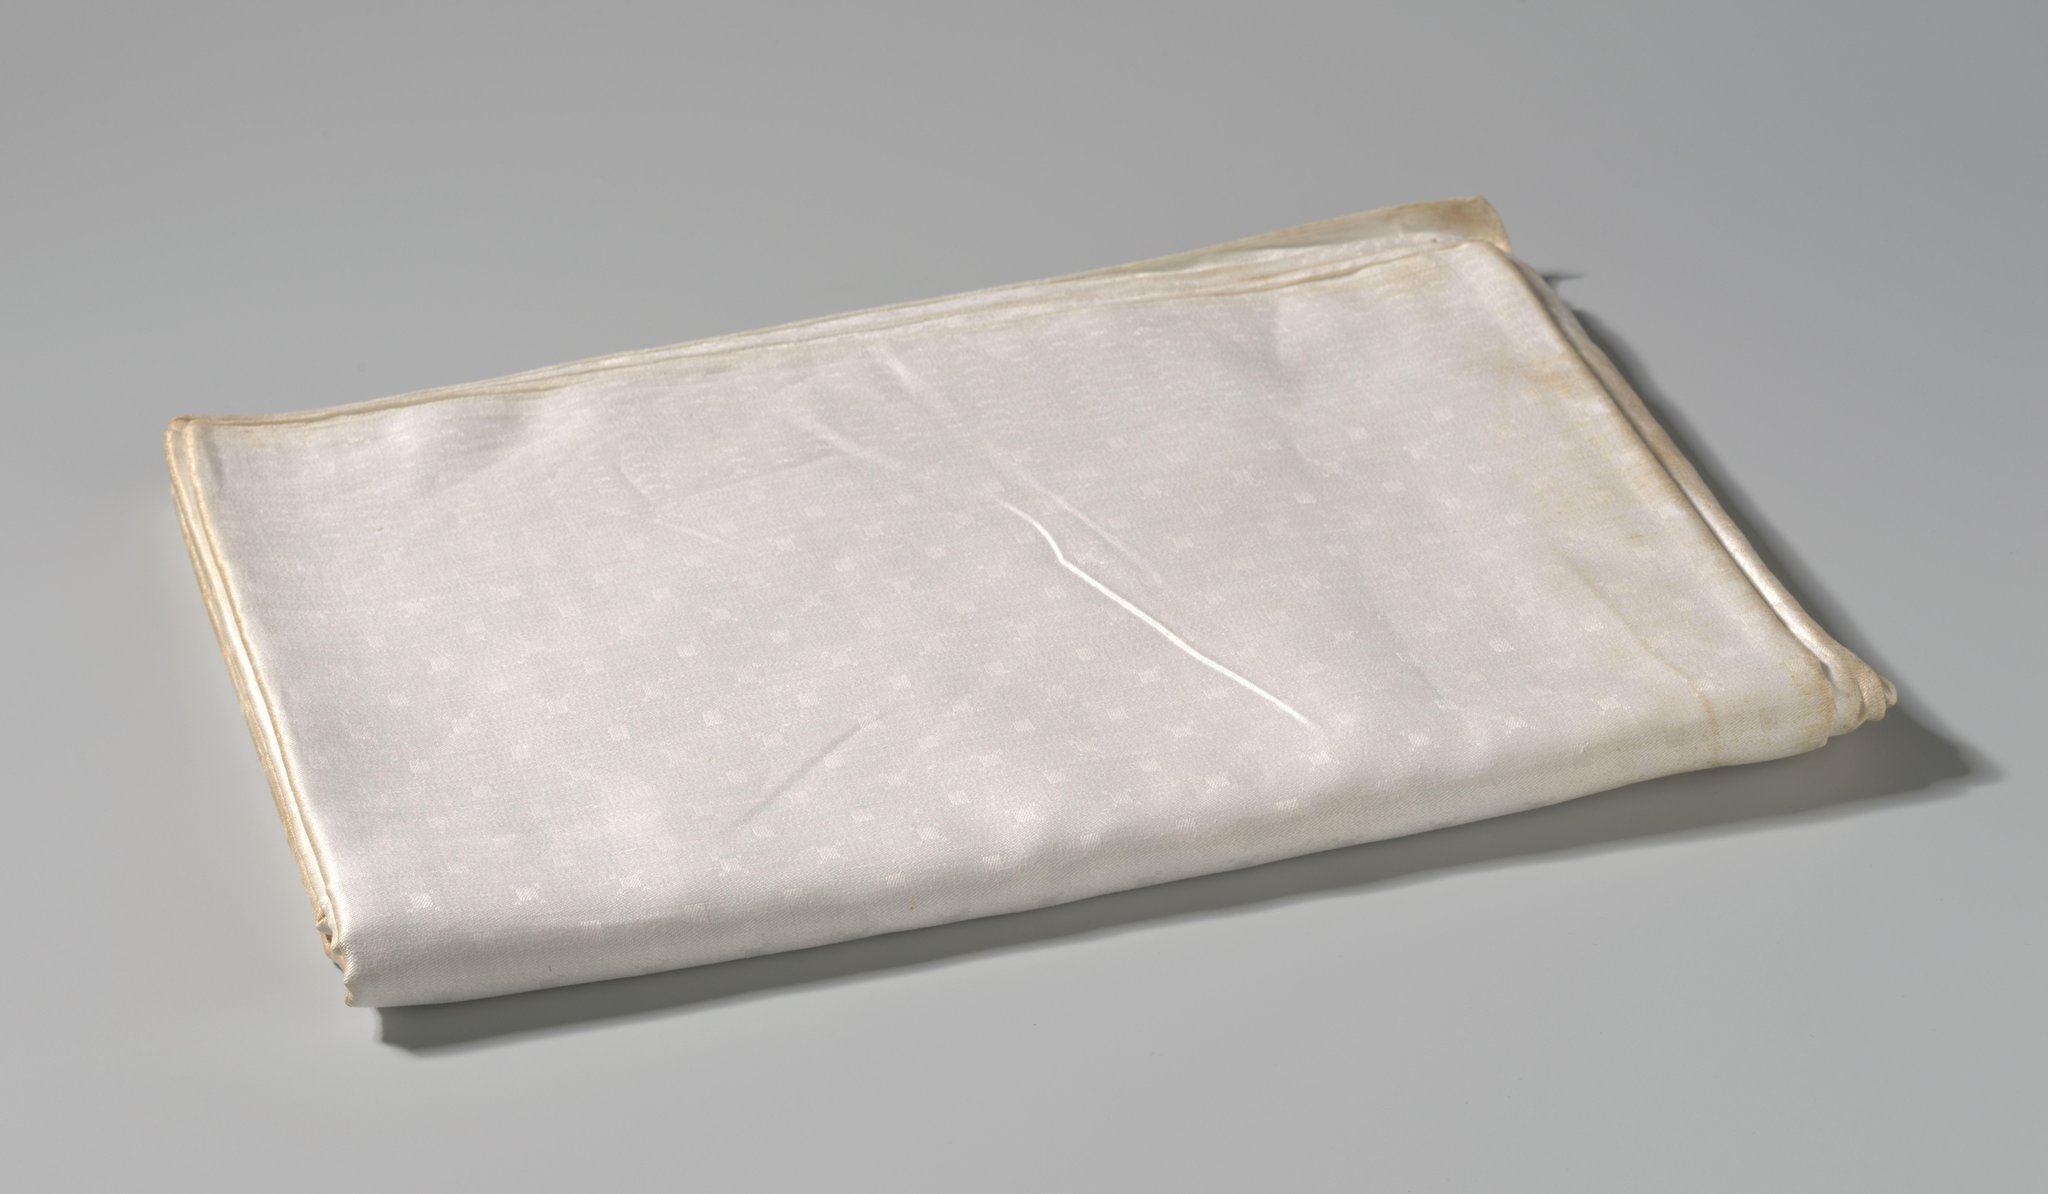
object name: tablecloth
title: Pellen, z.g. speldenkussenpatroon. Merk: HP13.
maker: Anonymous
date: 1800-1866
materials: linen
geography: northern netherlands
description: Tafellaken van wit linnendamast met pellen patroon, z.g. speldenkussen, merk HP en 13